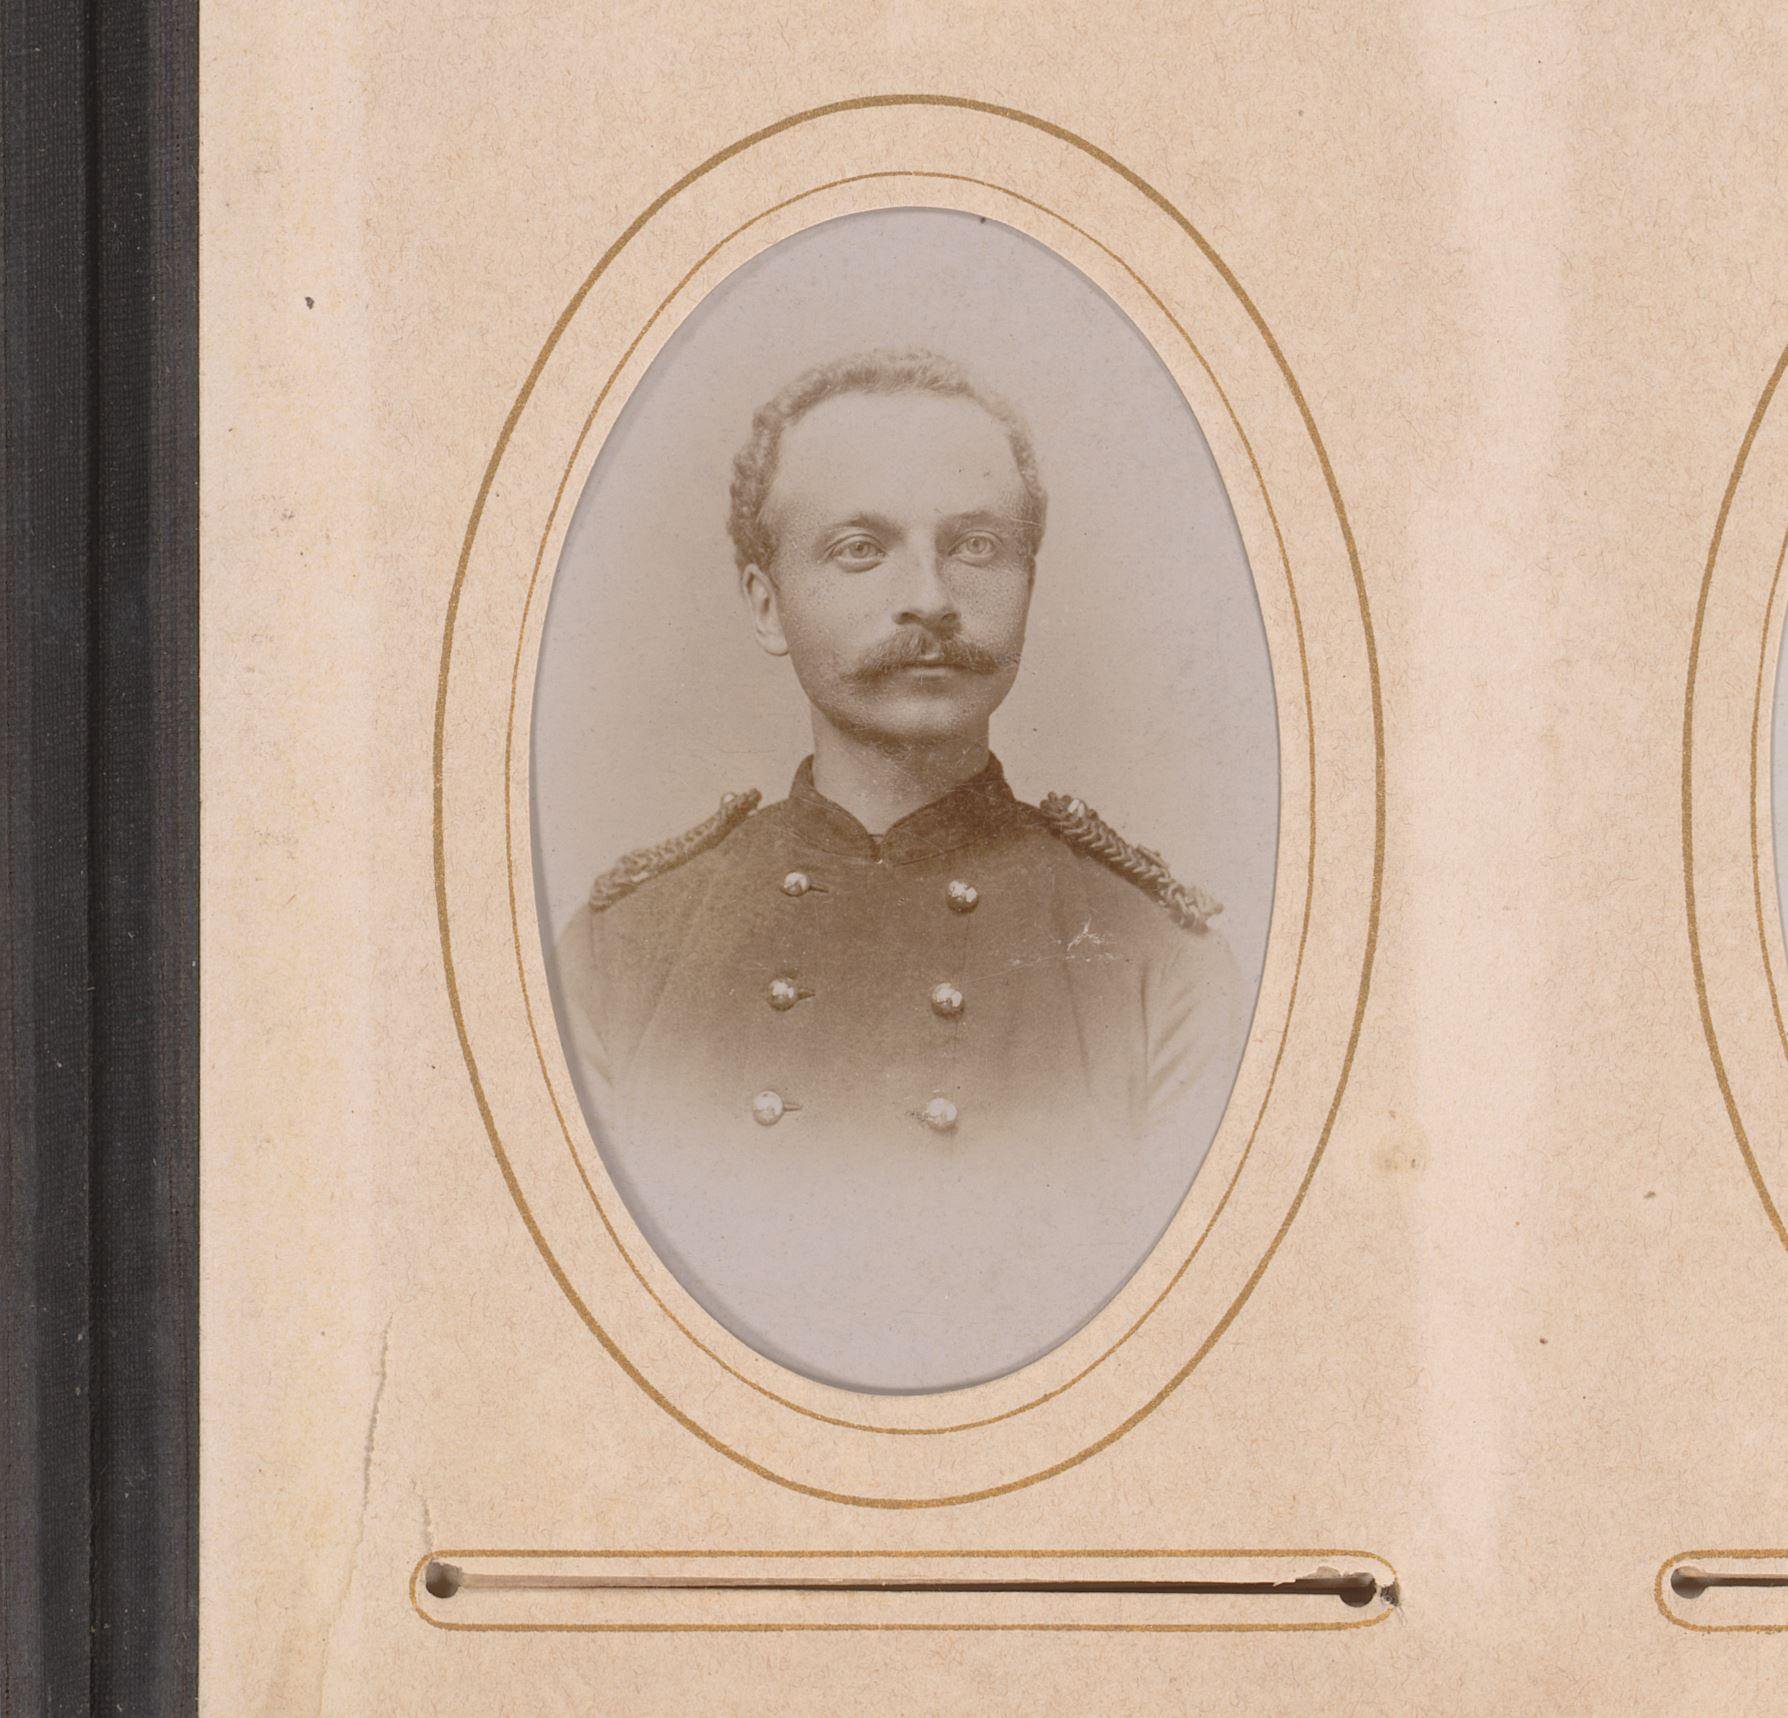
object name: carte de visite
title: Portret van een man met snor in uniform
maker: gerard karel martin hubert korfmacher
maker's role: fotograaf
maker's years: 1835-1914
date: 1880-1914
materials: cardboard, photographic support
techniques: collodion silver print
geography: nijmegen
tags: moustache, historical persons, (military) uniforms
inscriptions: inscription: ‘G. Korfmacher/ Nijmegen/ Hoek Molenstraat B 678’, annotation: ‘[H ...]’